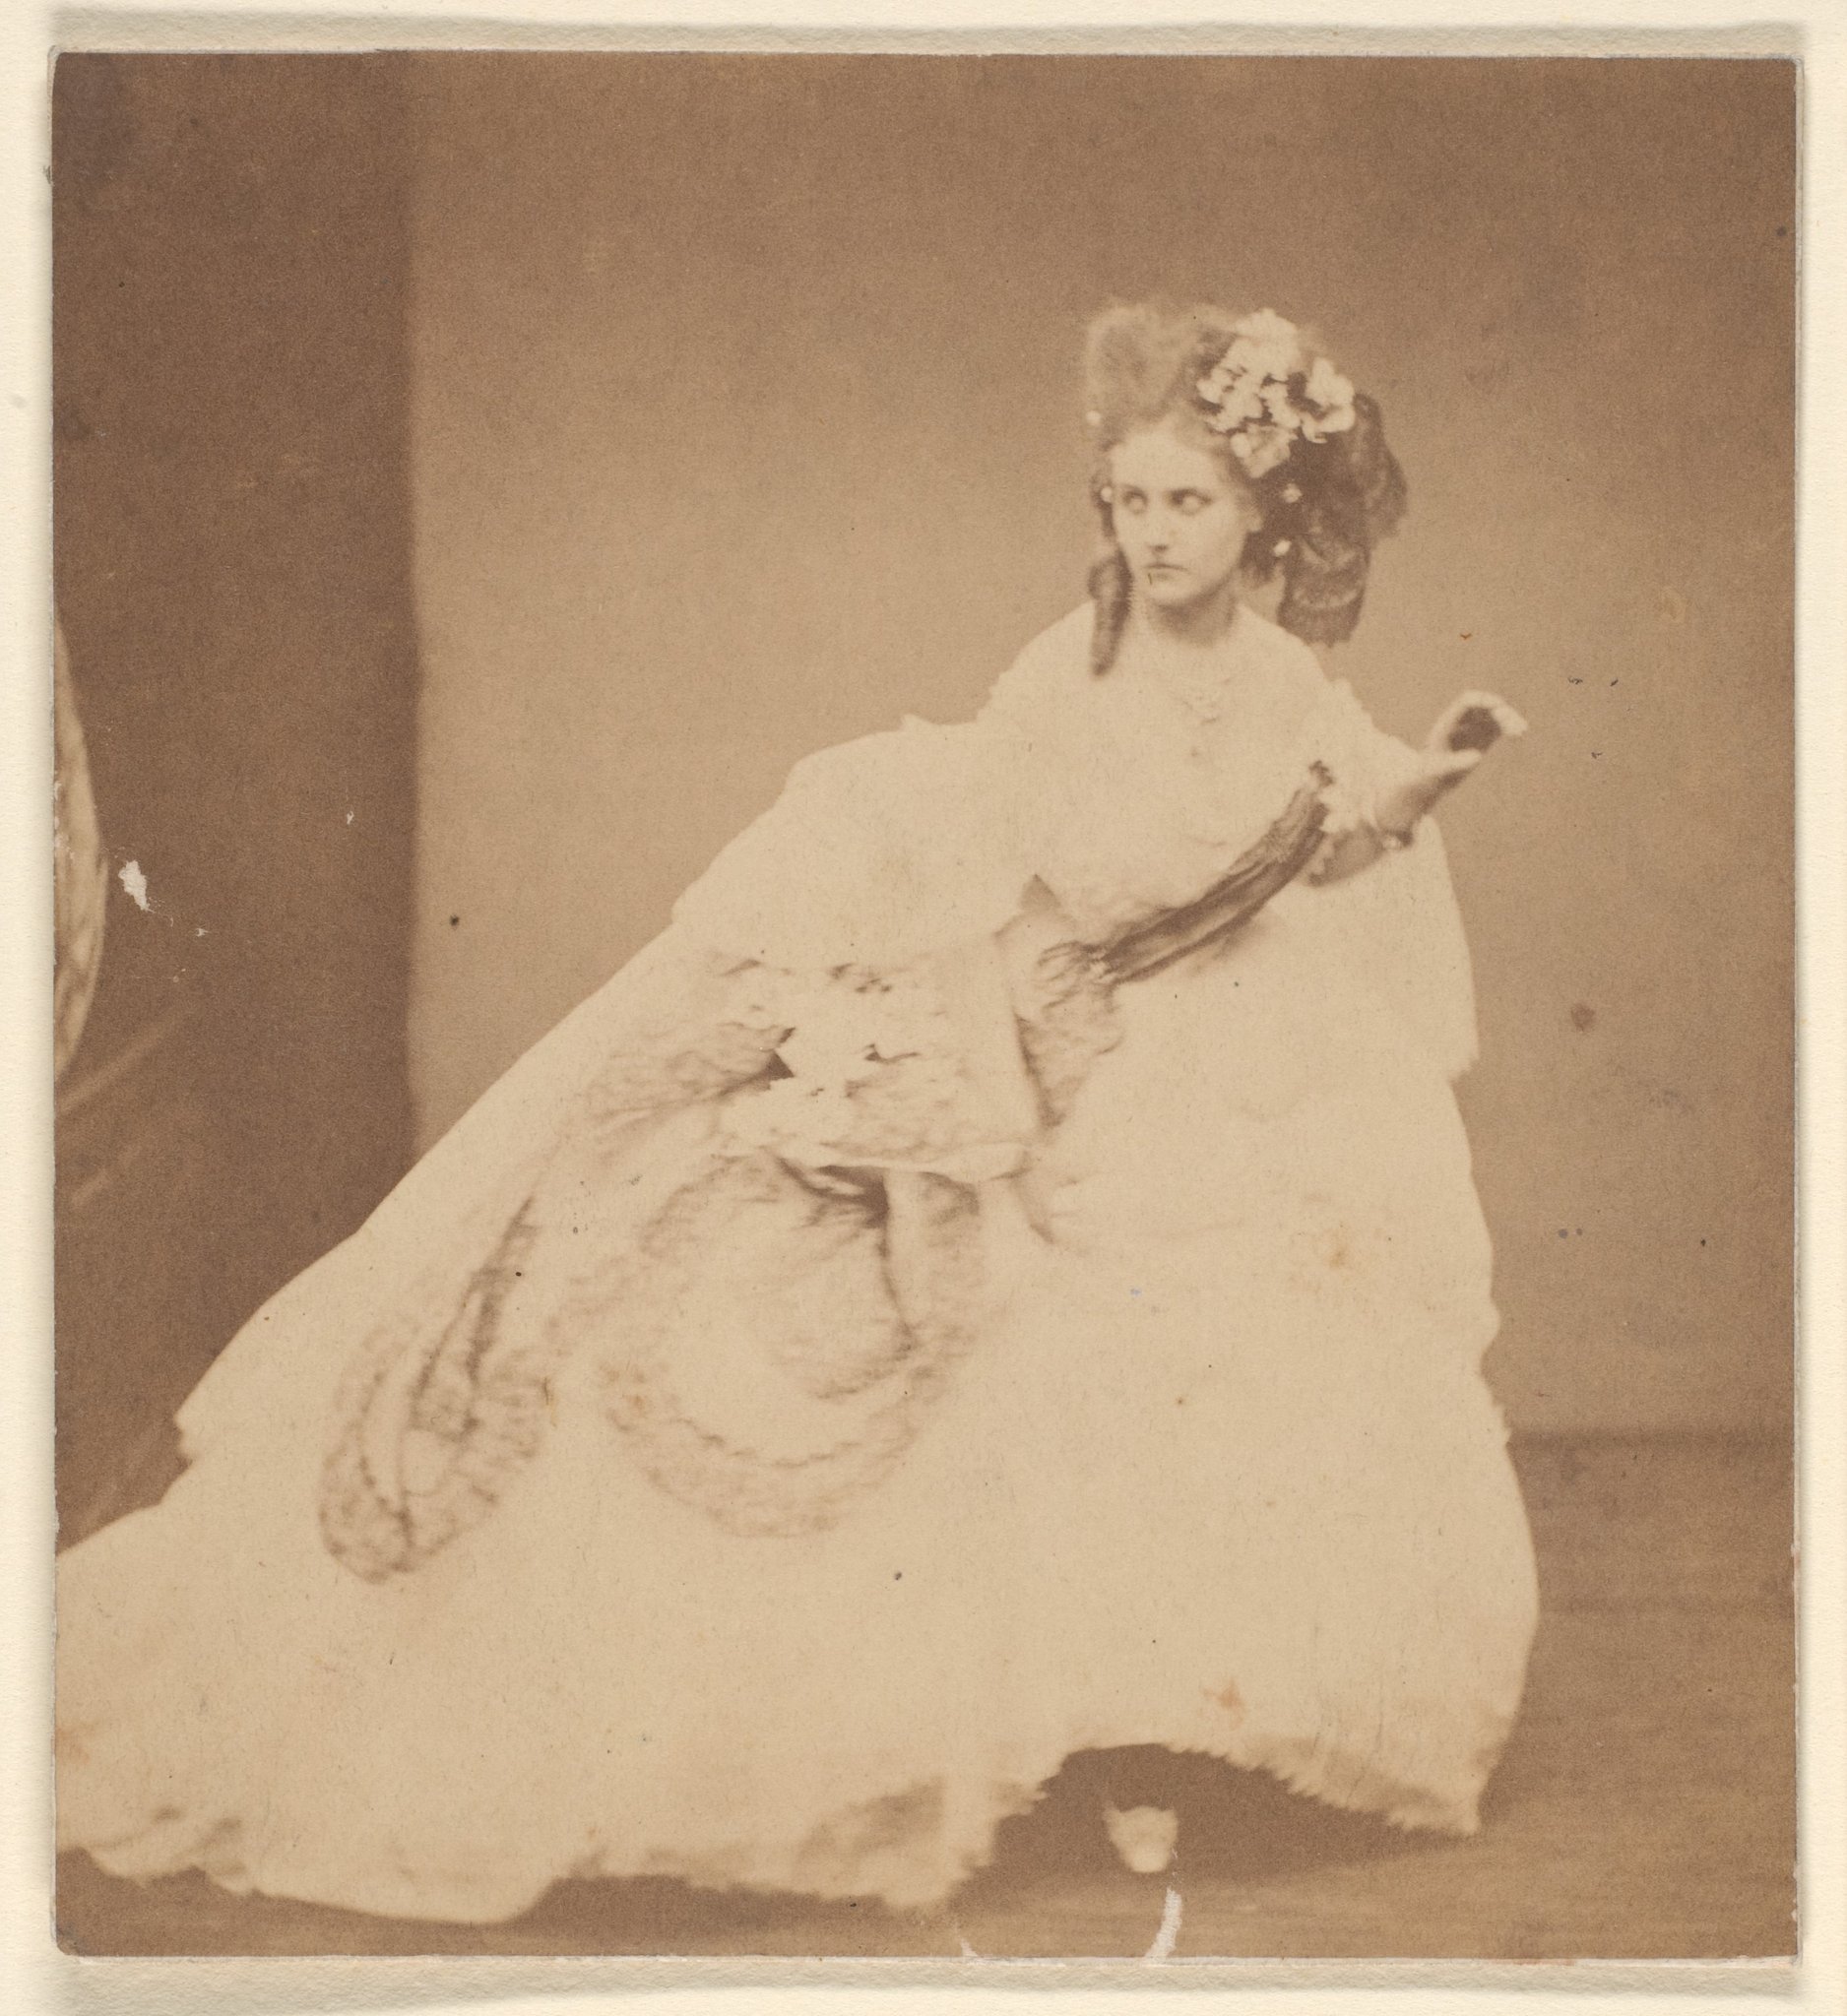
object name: photograph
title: La Frayeur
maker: pierre-louis pierson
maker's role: artist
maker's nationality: french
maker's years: 1822-1913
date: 1860-1869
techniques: albumen silver print, glass negative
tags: portraits,women